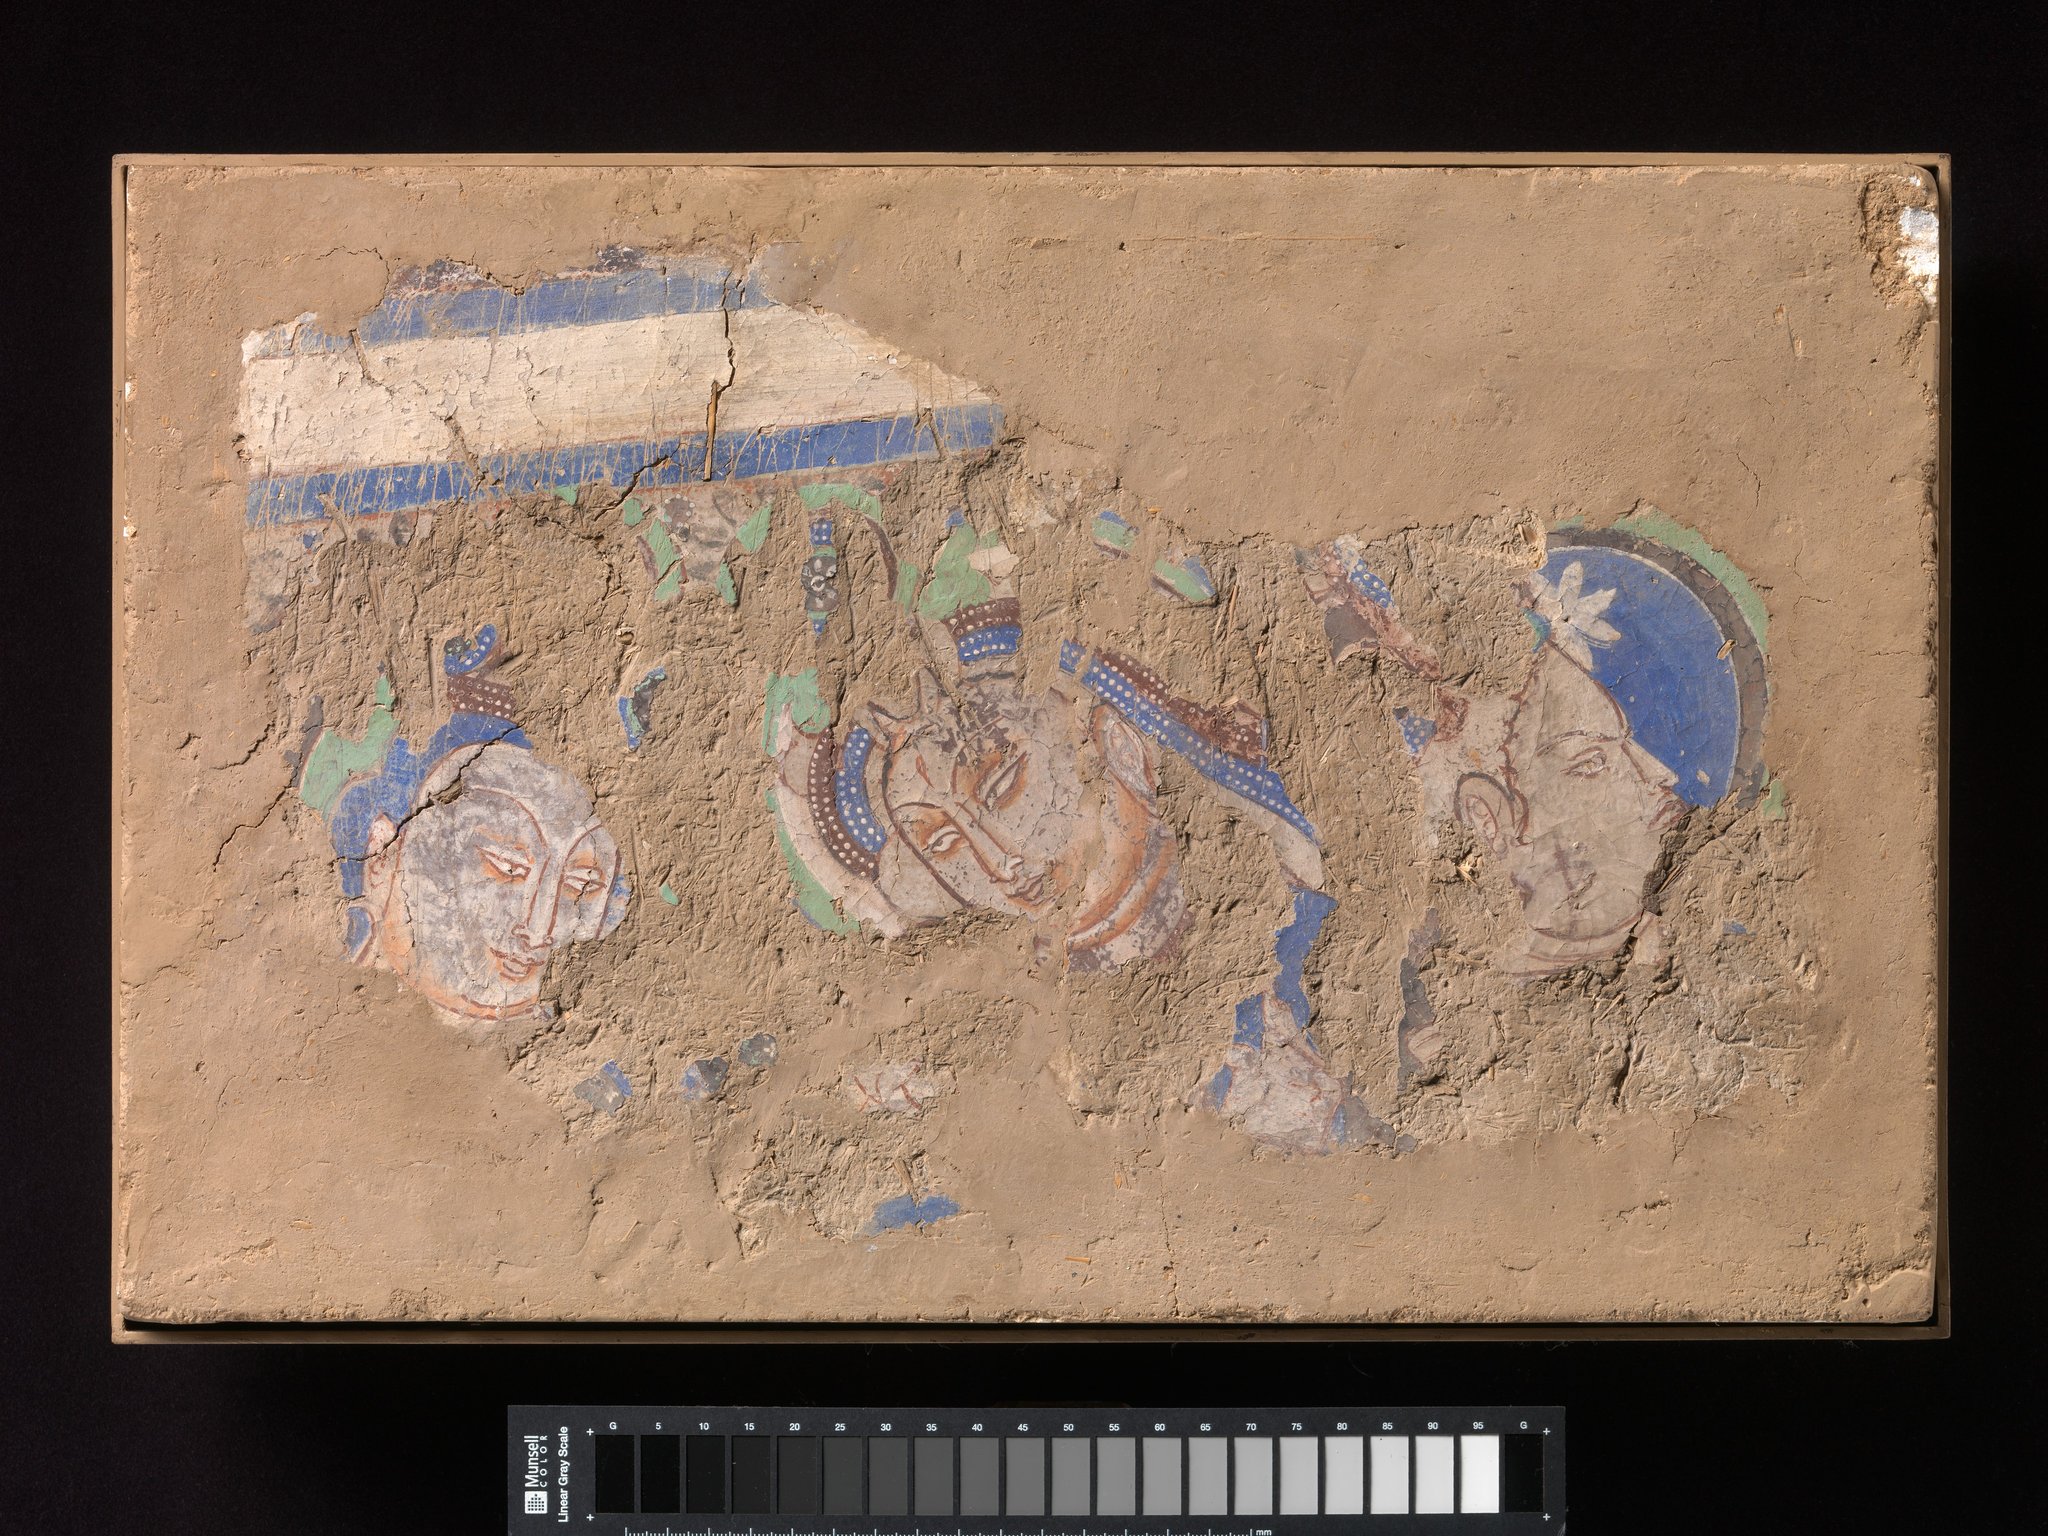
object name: wall painting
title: Three Bodhisattvas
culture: chinese, xinjiang uyghur autonomous region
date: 501-700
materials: mud, pigment, plaster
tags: buddhism,bodhisattvas